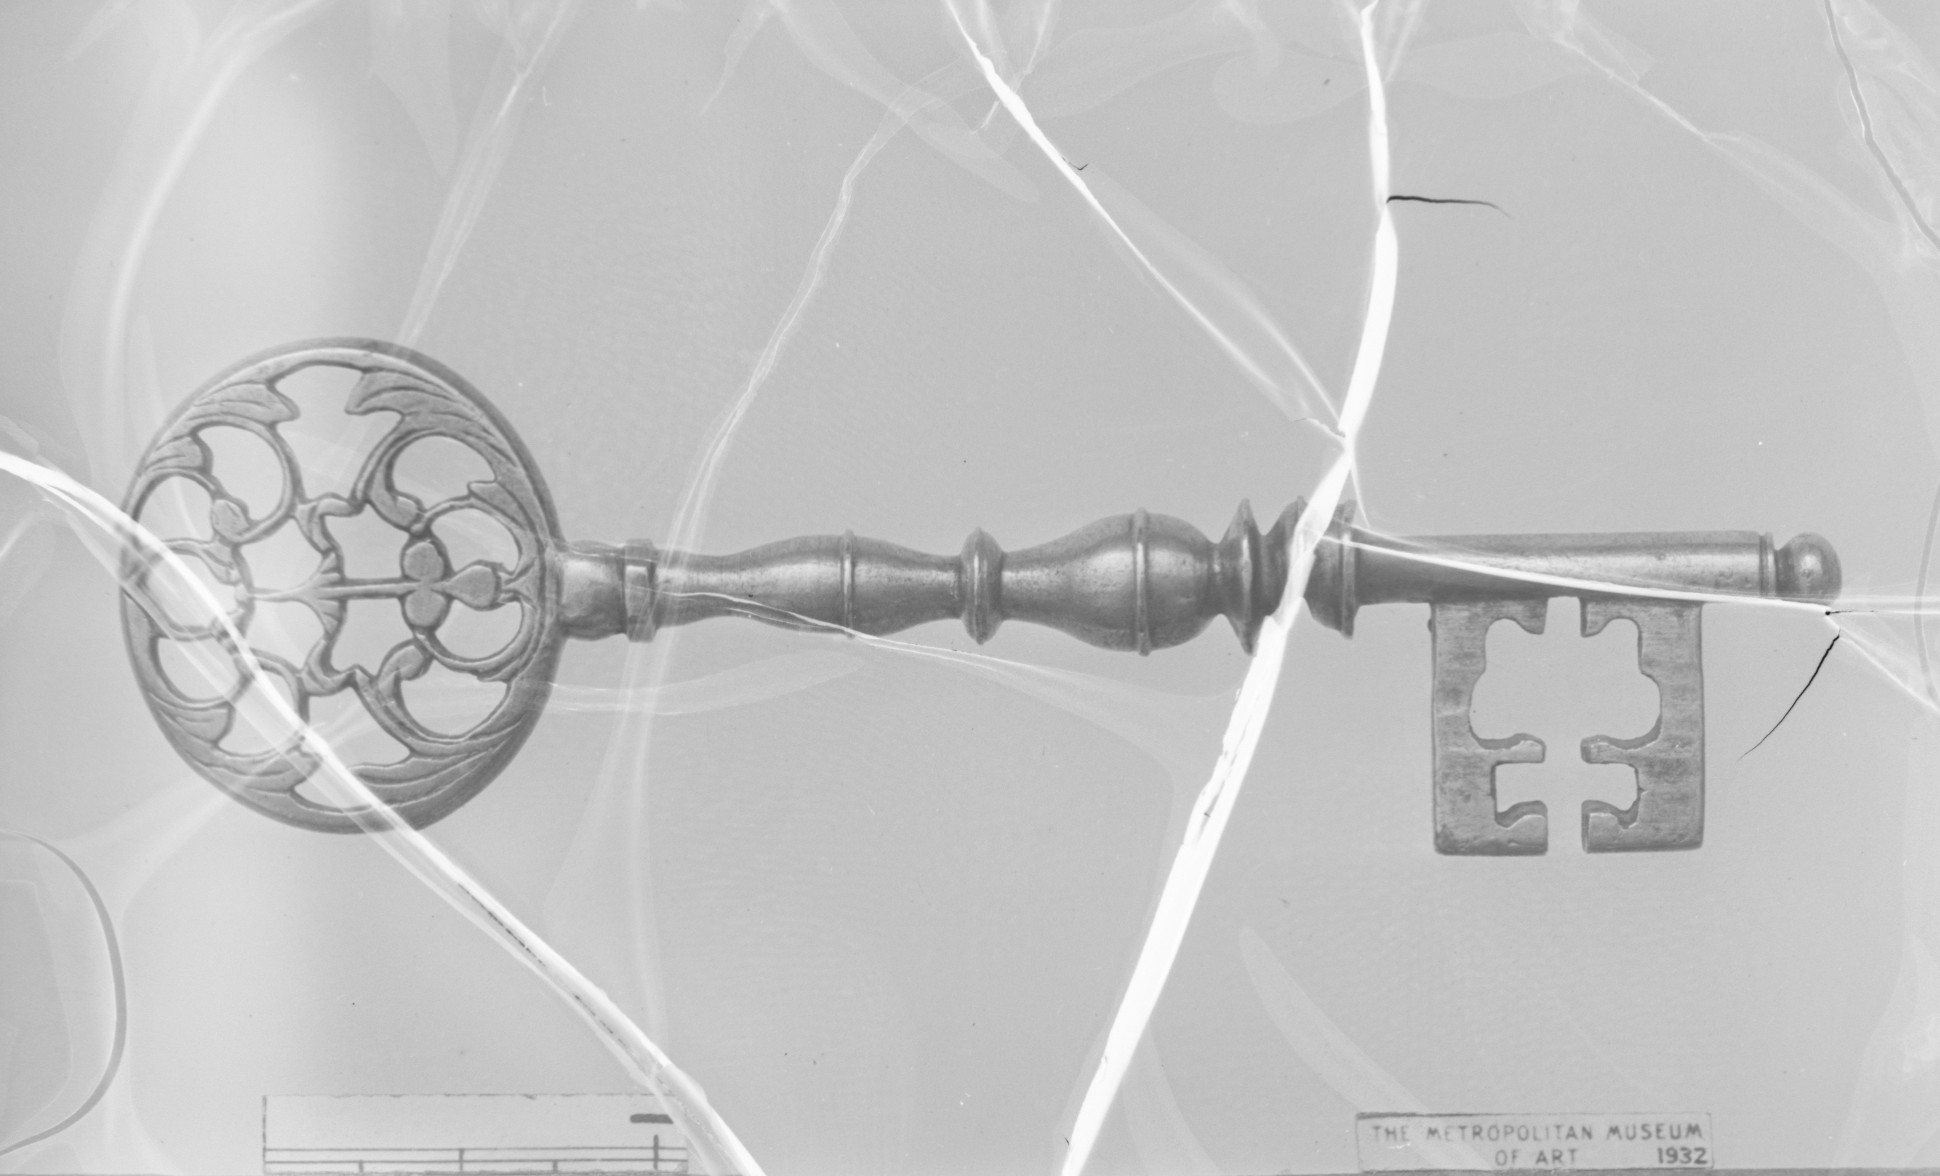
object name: key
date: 1701-1800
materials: iron